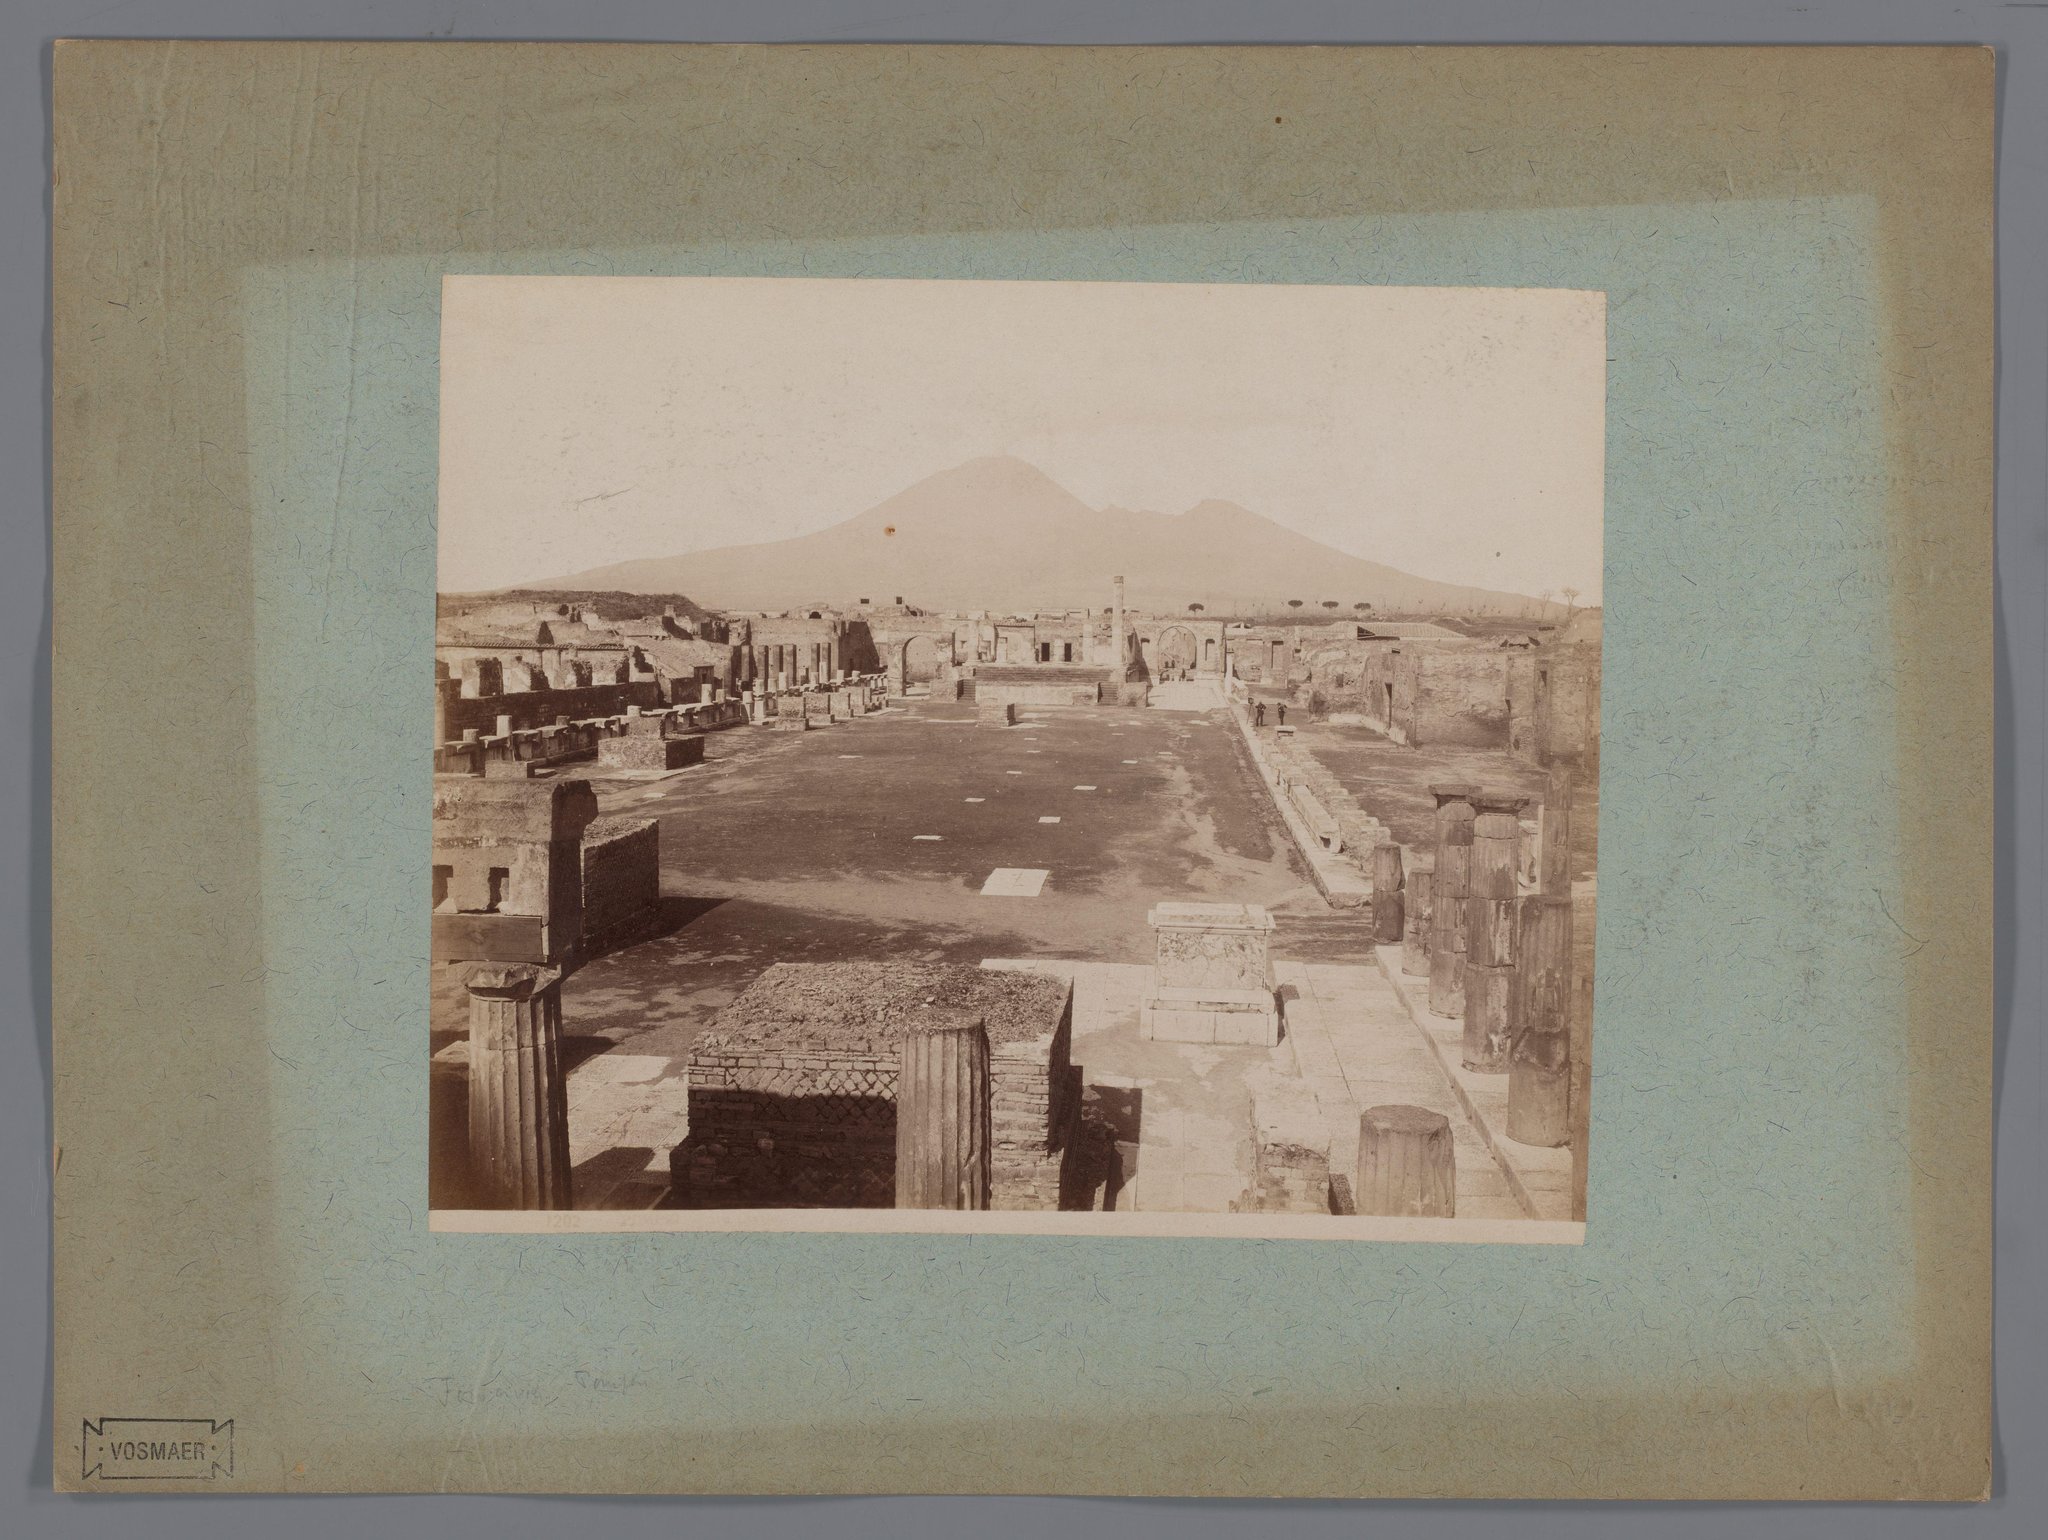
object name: photograph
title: Pompei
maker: giorgio sommer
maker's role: fotograaf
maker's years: 1834-1914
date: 1863-1875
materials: cardboard, paper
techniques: albumen print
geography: pompeii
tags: square, place, circus, etc., ruin of a building ~ architecture, landscape with ruins, portrait, self-portrait of photographer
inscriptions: collector's mark: ‘VOSMAER’, number: ‘1202.’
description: Rechtsachter op het plein is een andere fotograaf aan het werk.